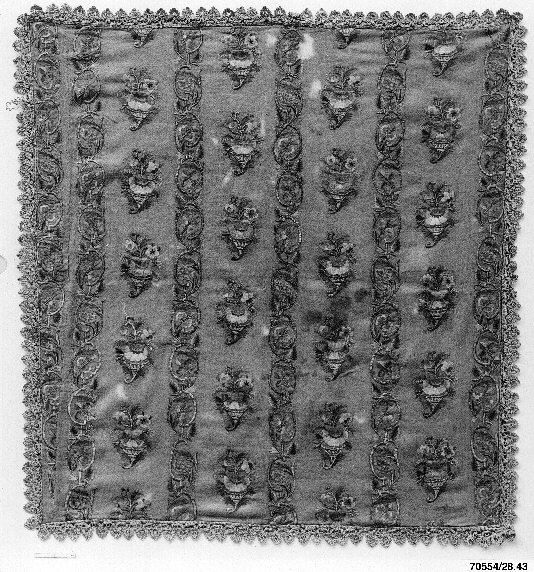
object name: square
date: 1701-1800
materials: metal thread, silk, wool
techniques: embroidery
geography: turkey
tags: flowers